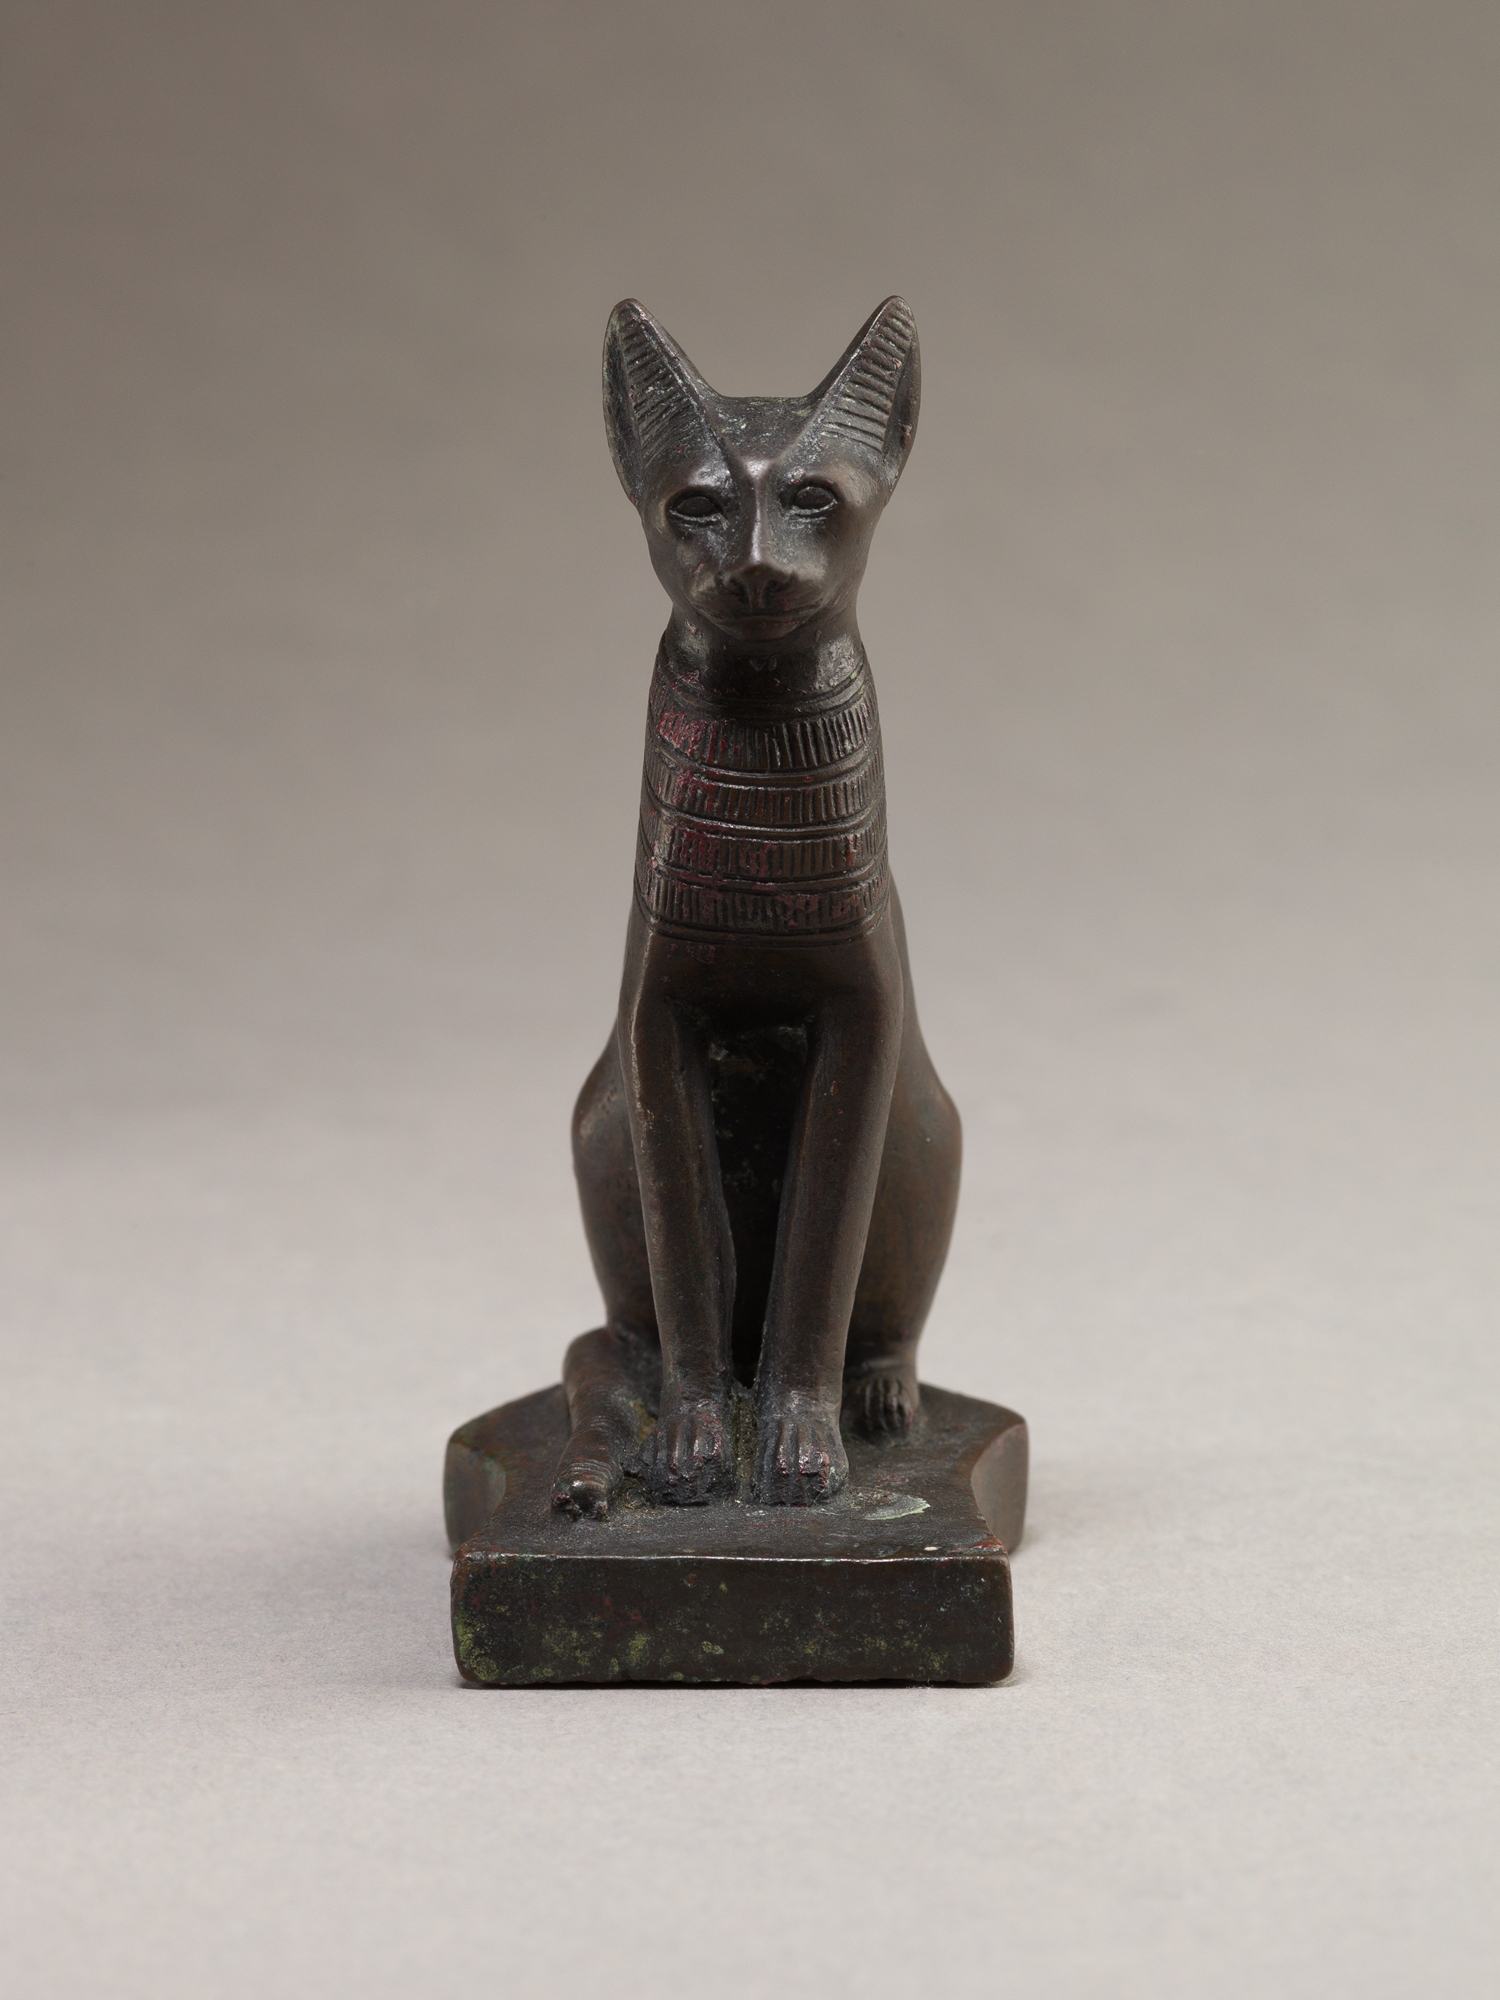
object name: statuette, cat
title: Statuette of a cat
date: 664-630 BCE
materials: metal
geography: egypt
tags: cats